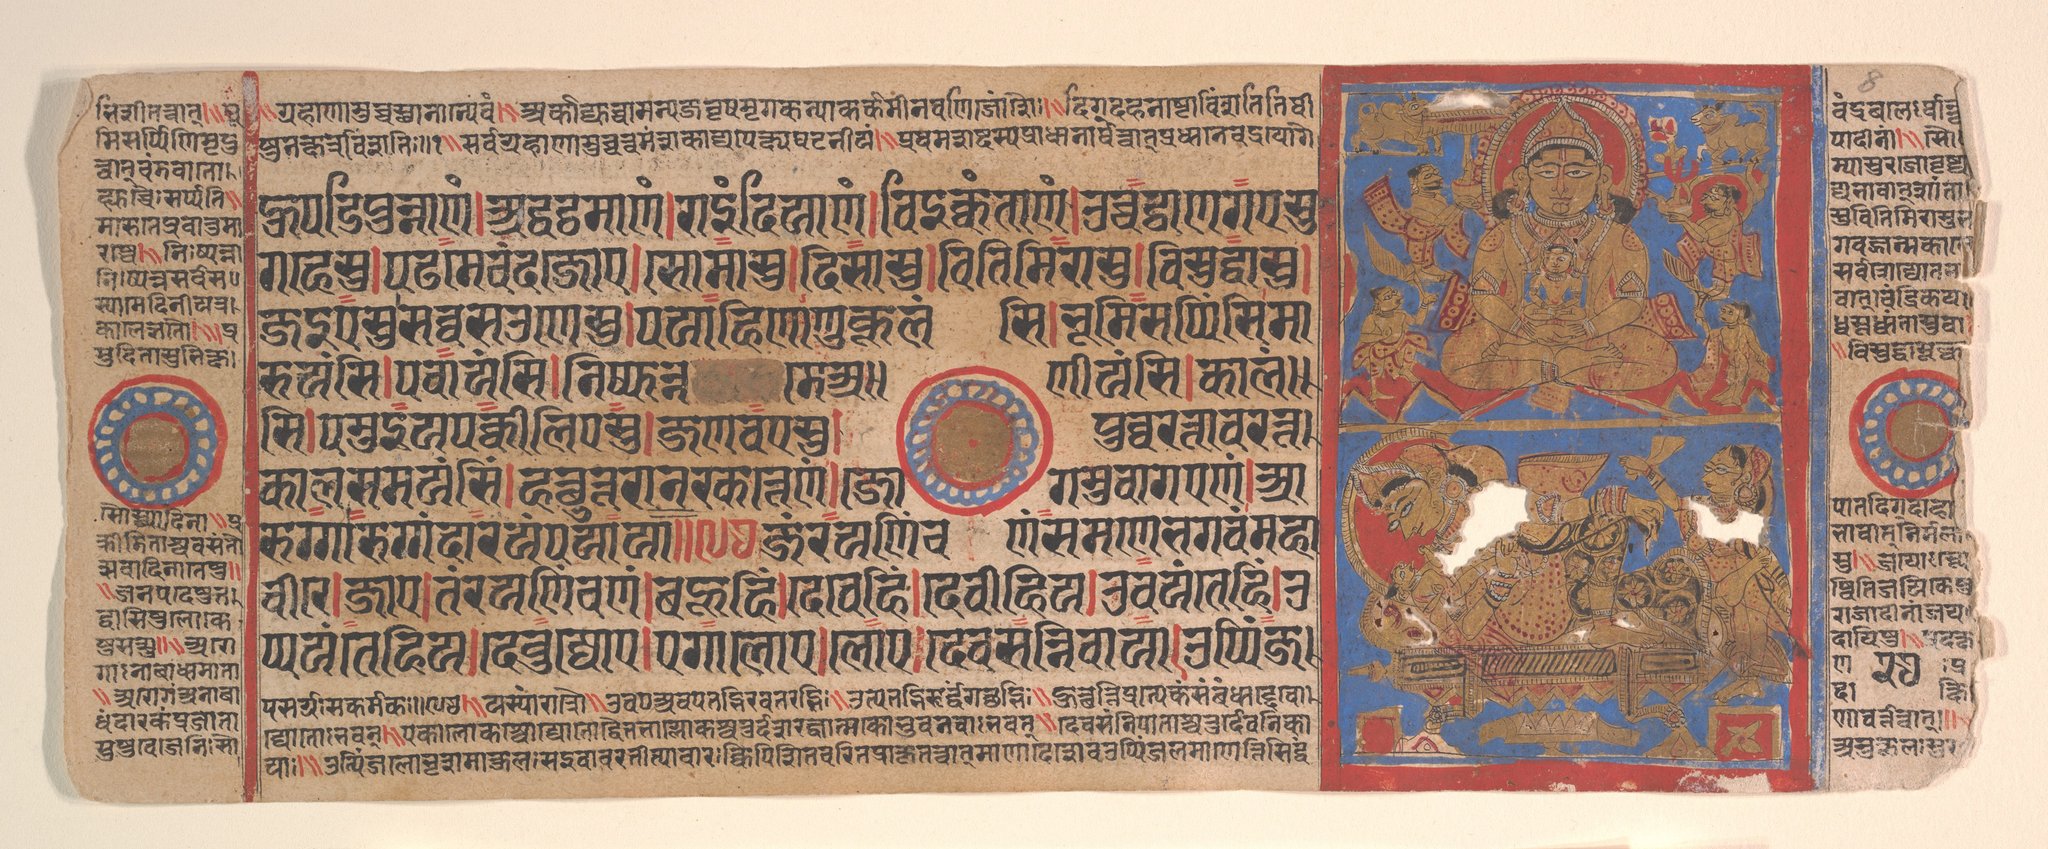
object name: folio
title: Leaf from a Kalpa Sutra (Jain Book of Rituals)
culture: indian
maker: bhadrabahu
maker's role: artist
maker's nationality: indian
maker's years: 356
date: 1401-1500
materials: gold, ink, paper, watercolor